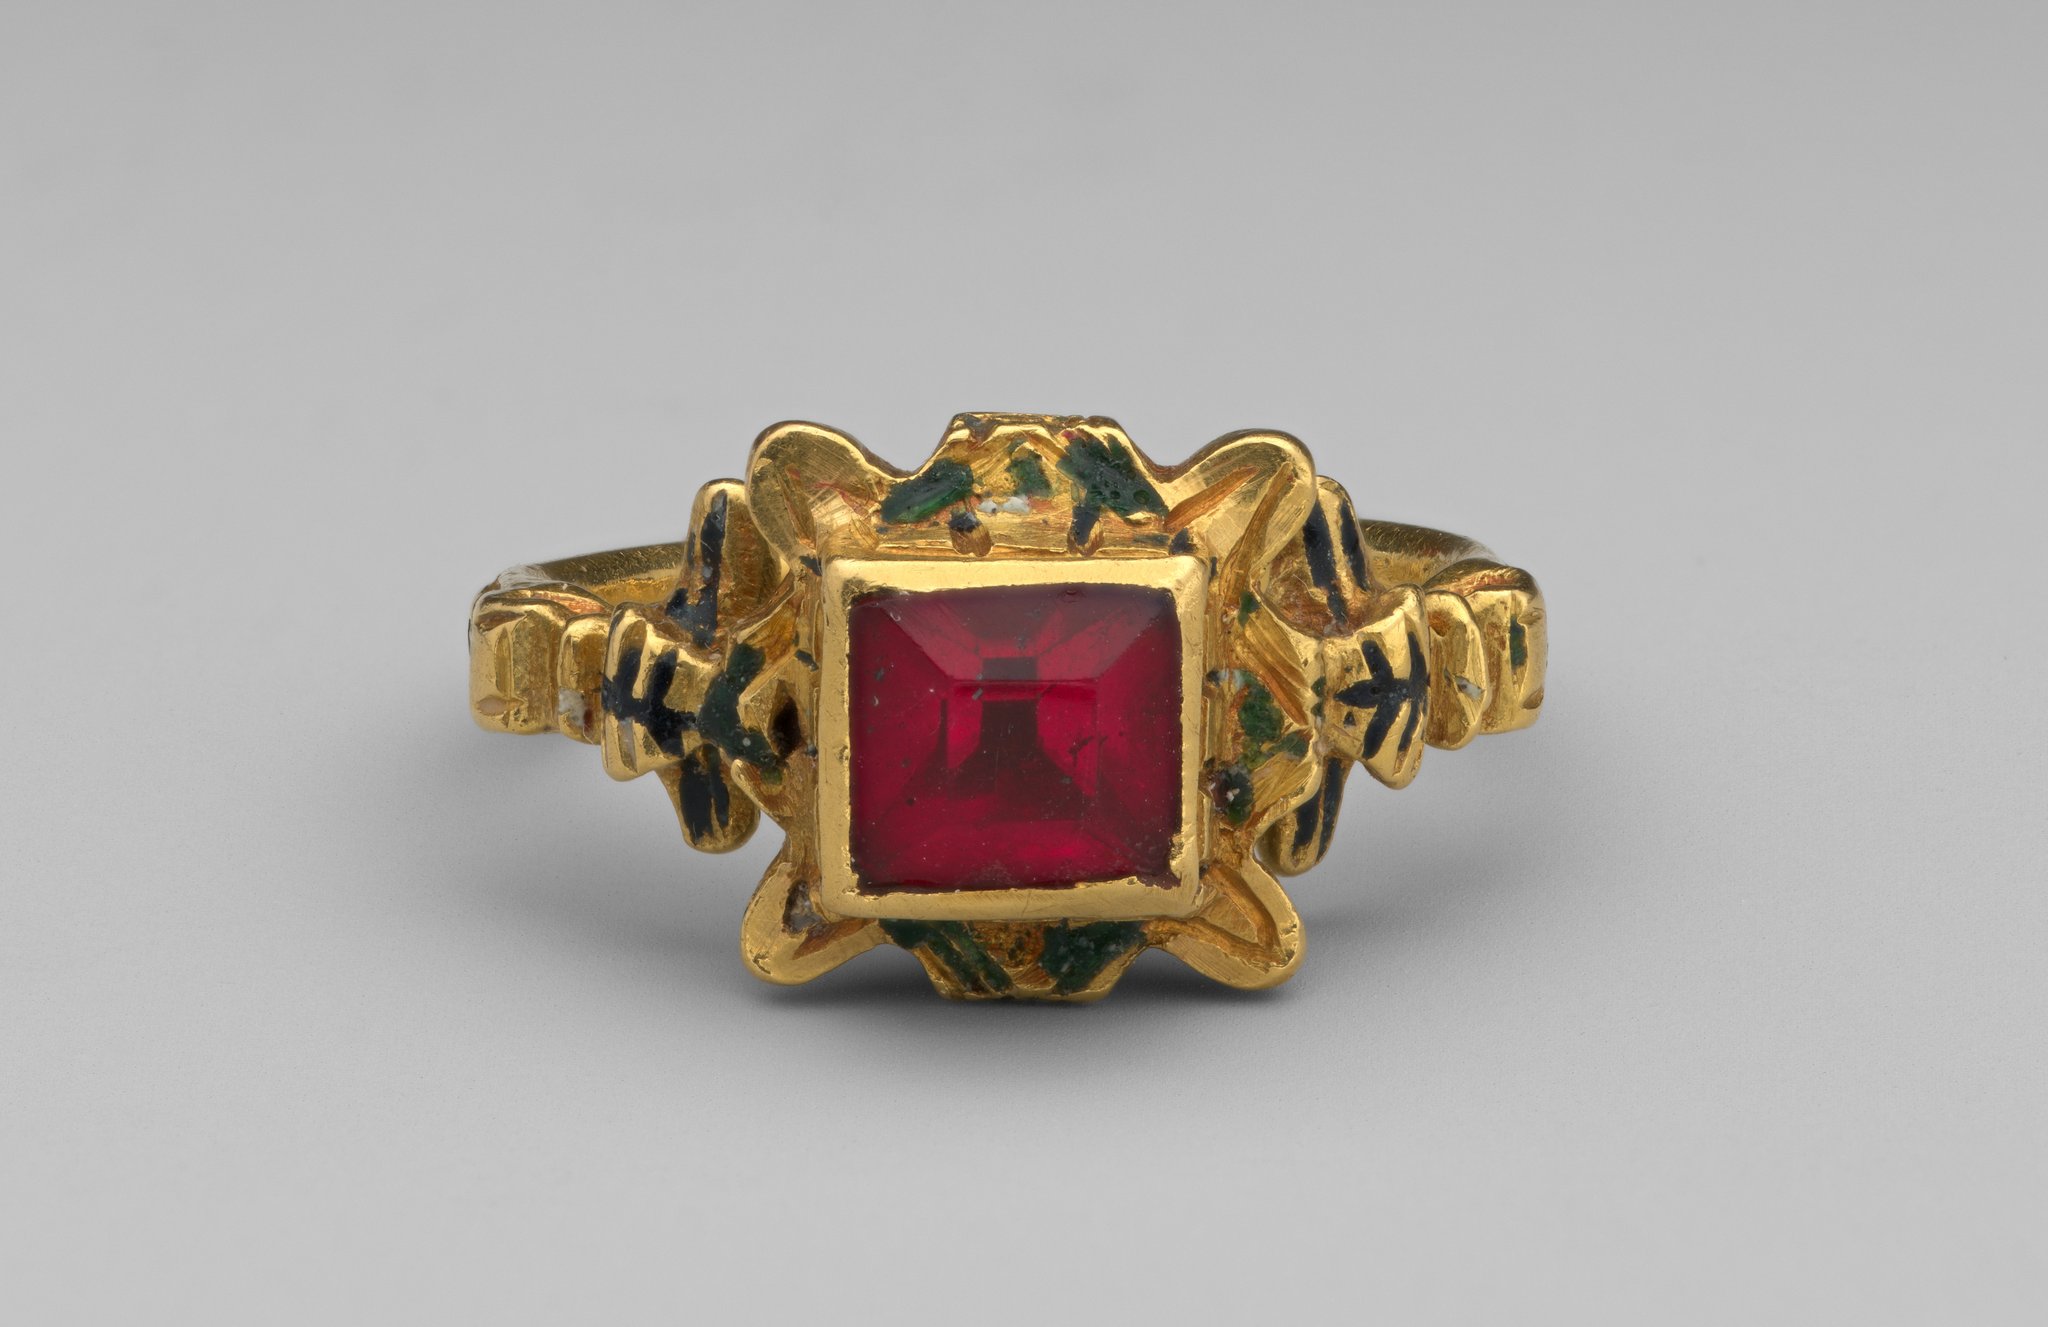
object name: ring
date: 1801-1900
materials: gold